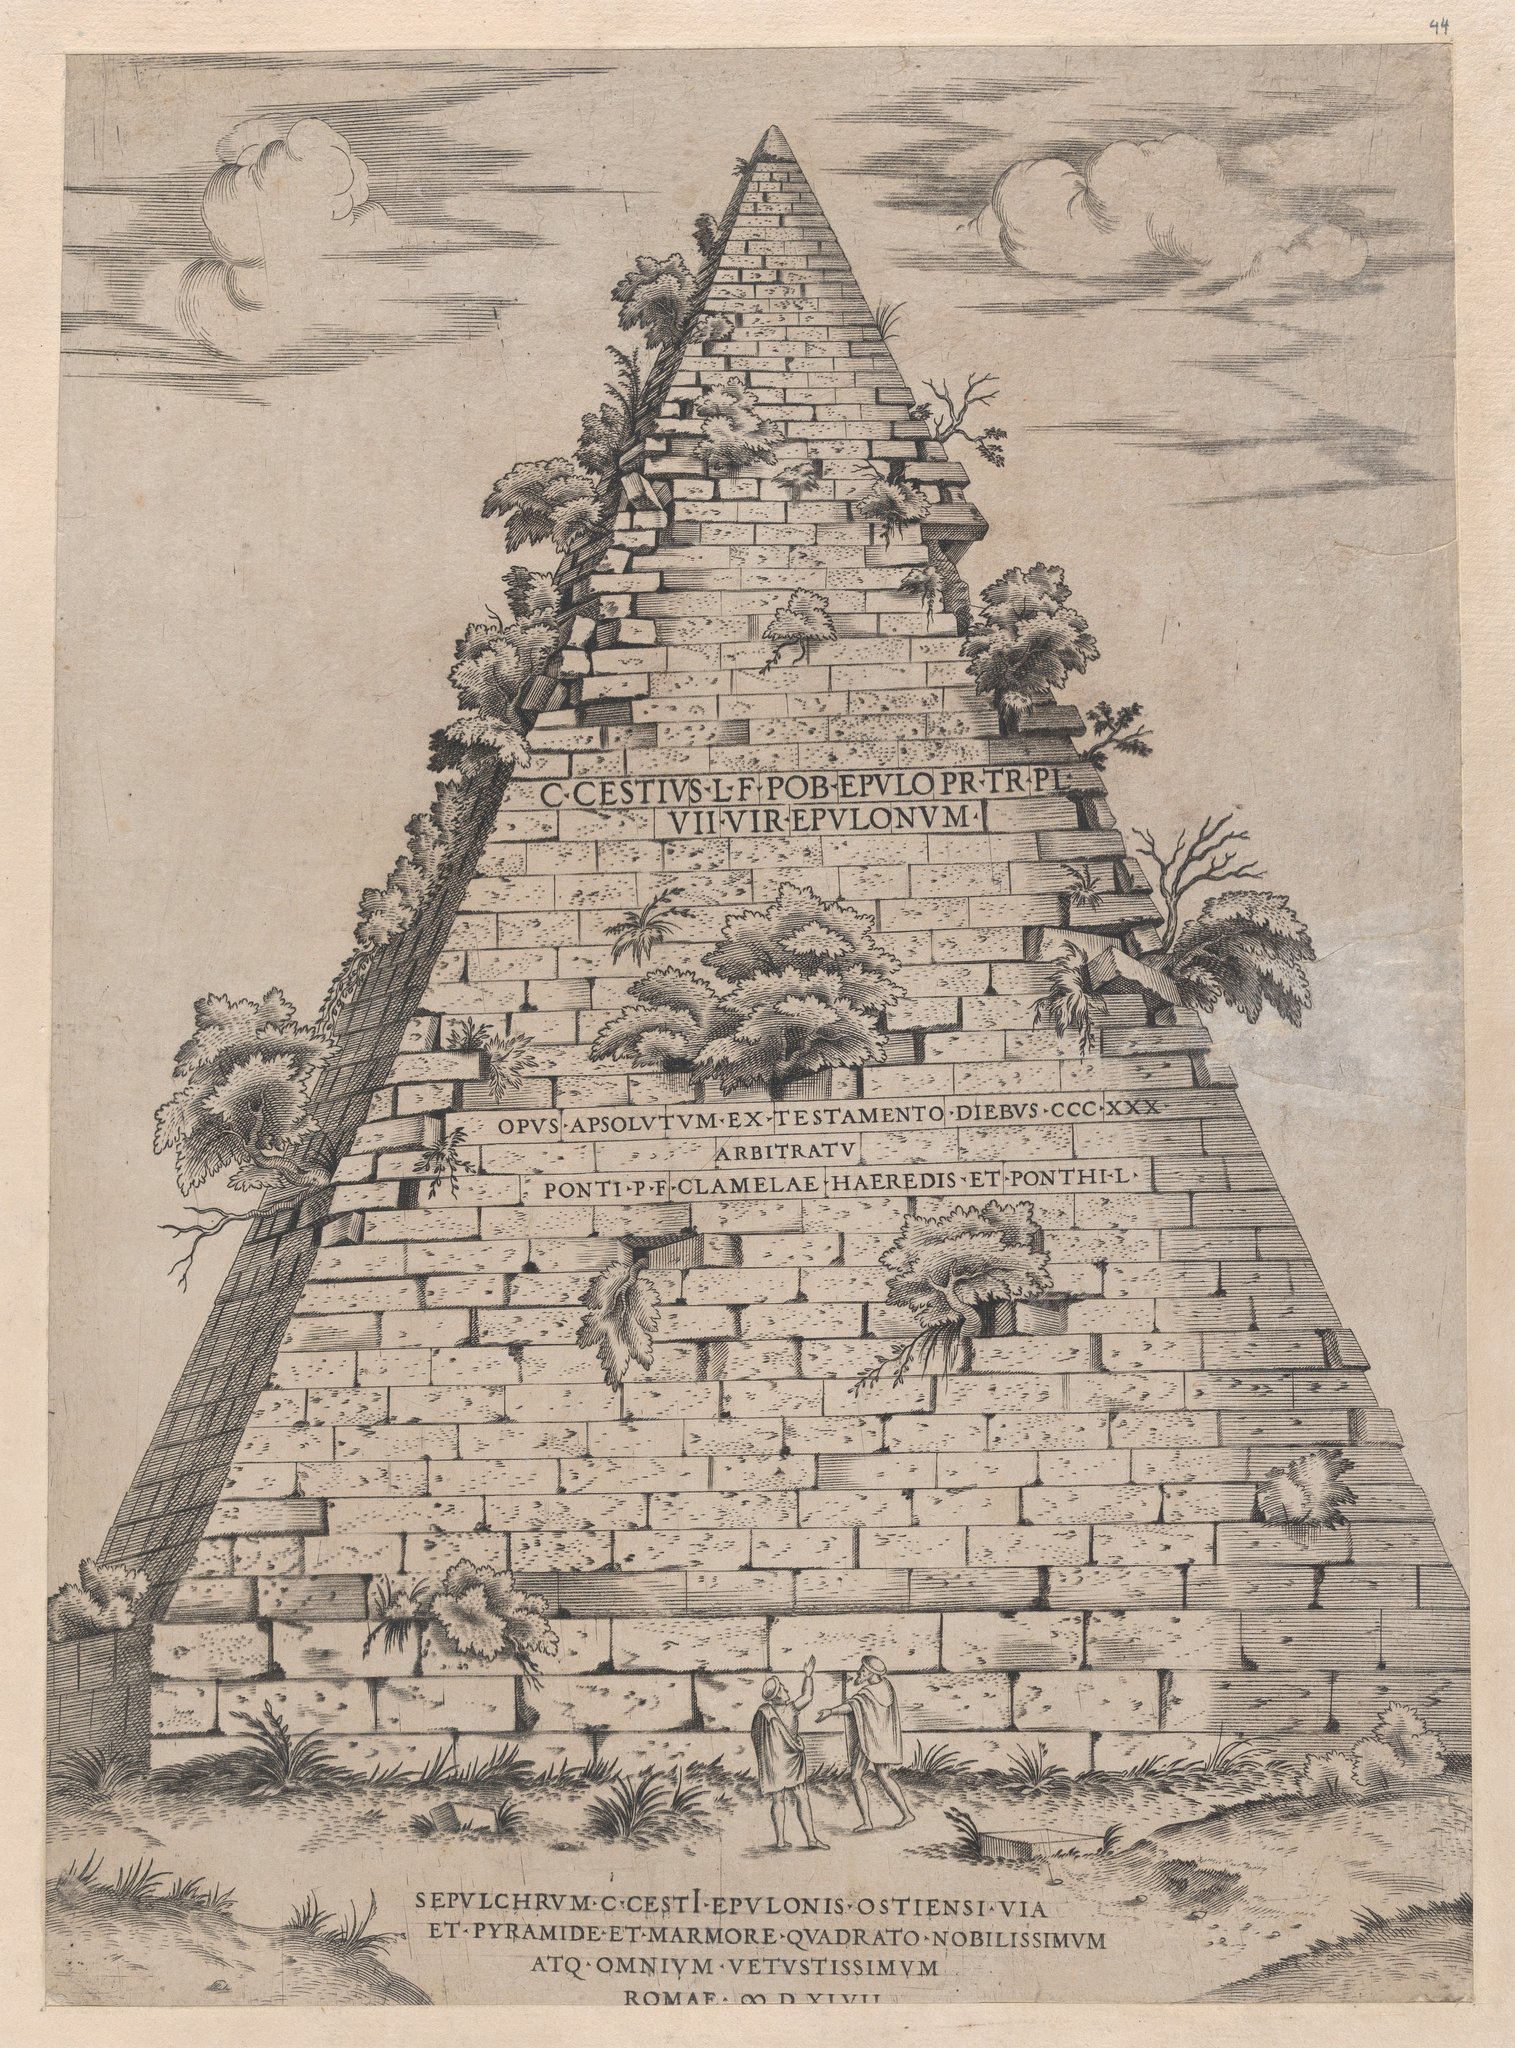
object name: print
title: Pyramid of Caius Cestius, from "Speculum Romanae Magnificentiae"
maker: Anonymous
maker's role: artist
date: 1547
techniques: engraving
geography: rome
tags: pyramids,rome